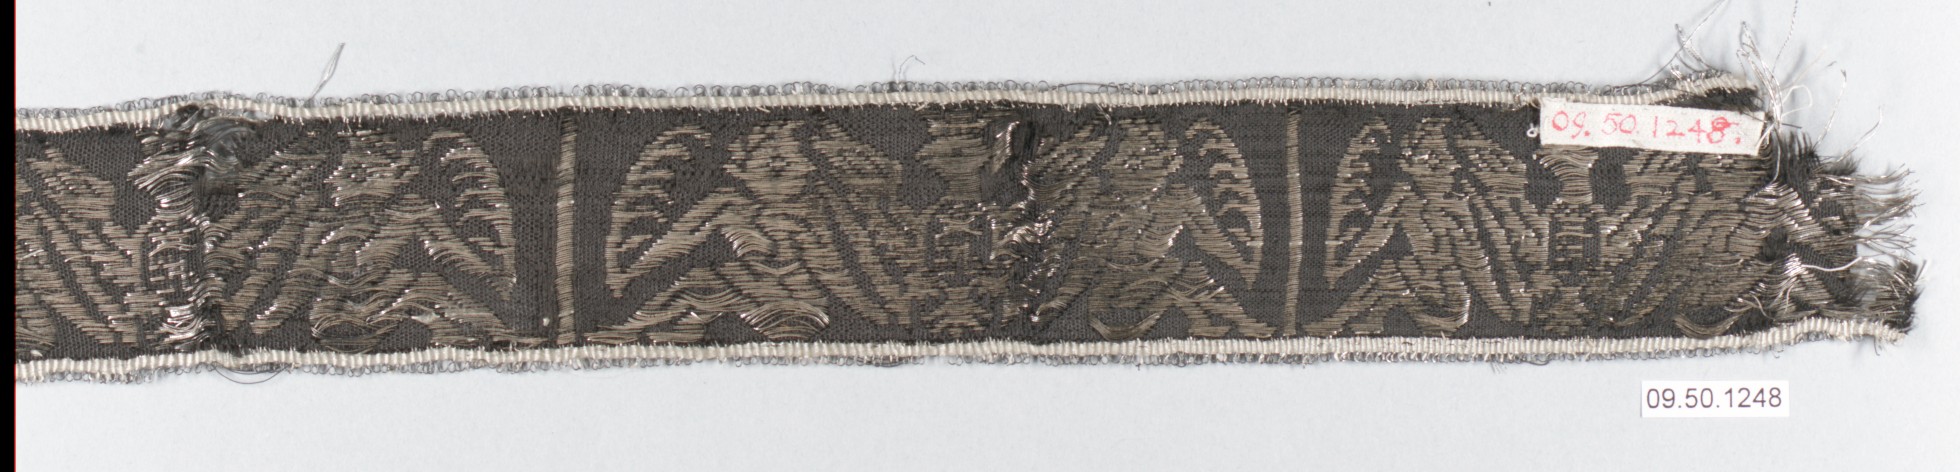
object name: galloon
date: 1701-1800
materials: metal thread, silk